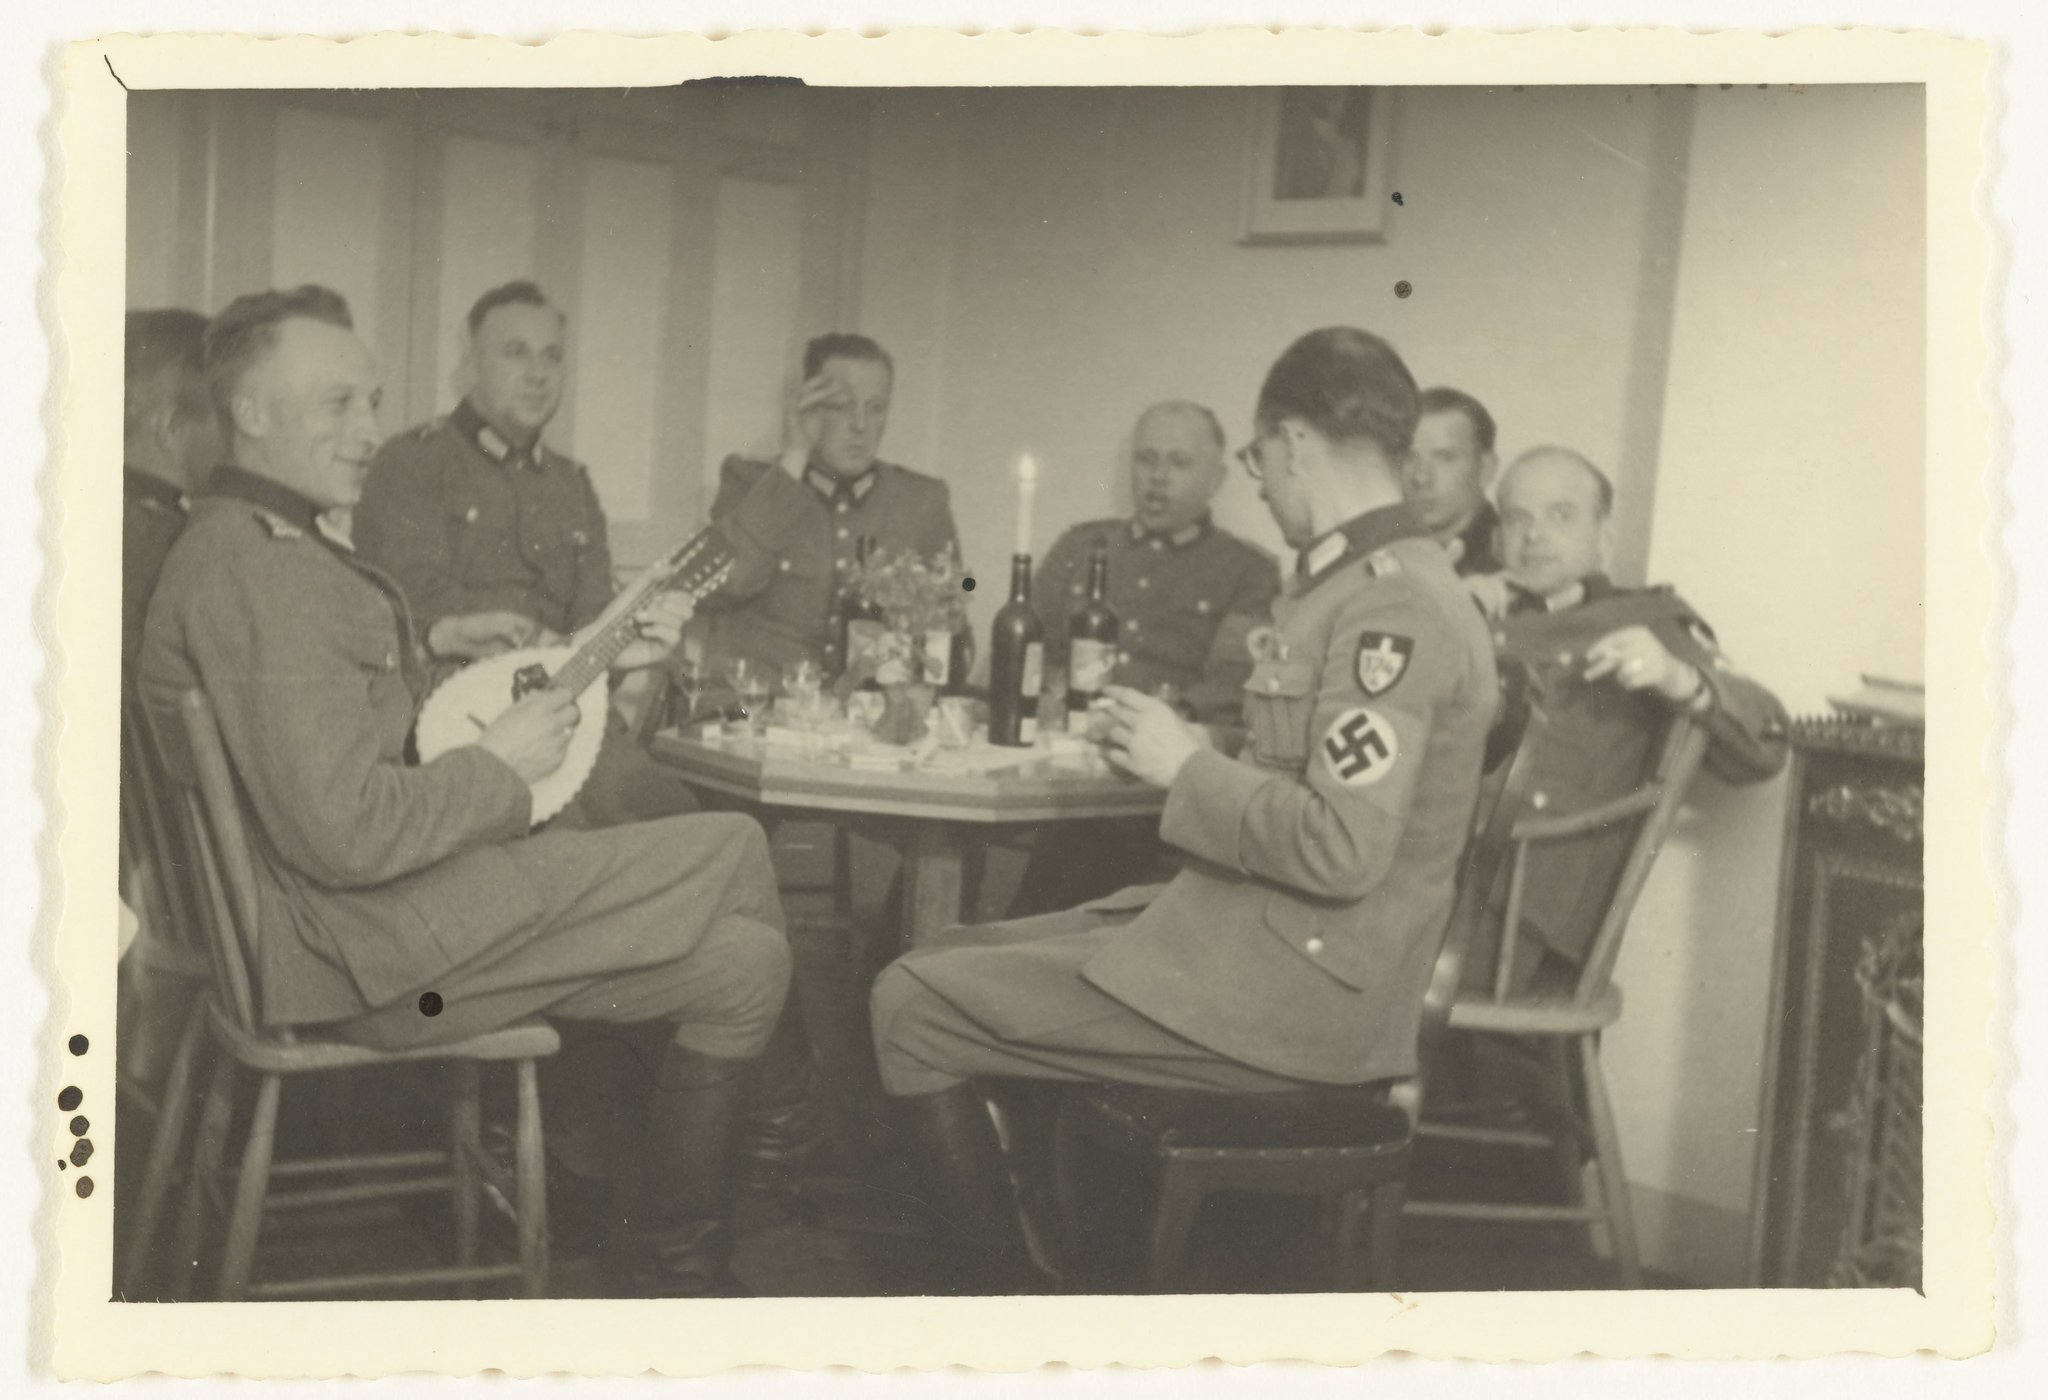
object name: photograph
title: Duitse soldaten vieren feest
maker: Anonymous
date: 1941-1942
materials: photographic support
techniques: gelatin silver print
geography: netherlands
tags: recreation ~ the soldier off duty, occupation ~ war, netherlands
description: Een groep Wehrmacht soldaten (Arbeidsdienst) vieren feest en zingen. Een van hen speelt op een mandoline. Op tafel drank en een kaars in een fles.